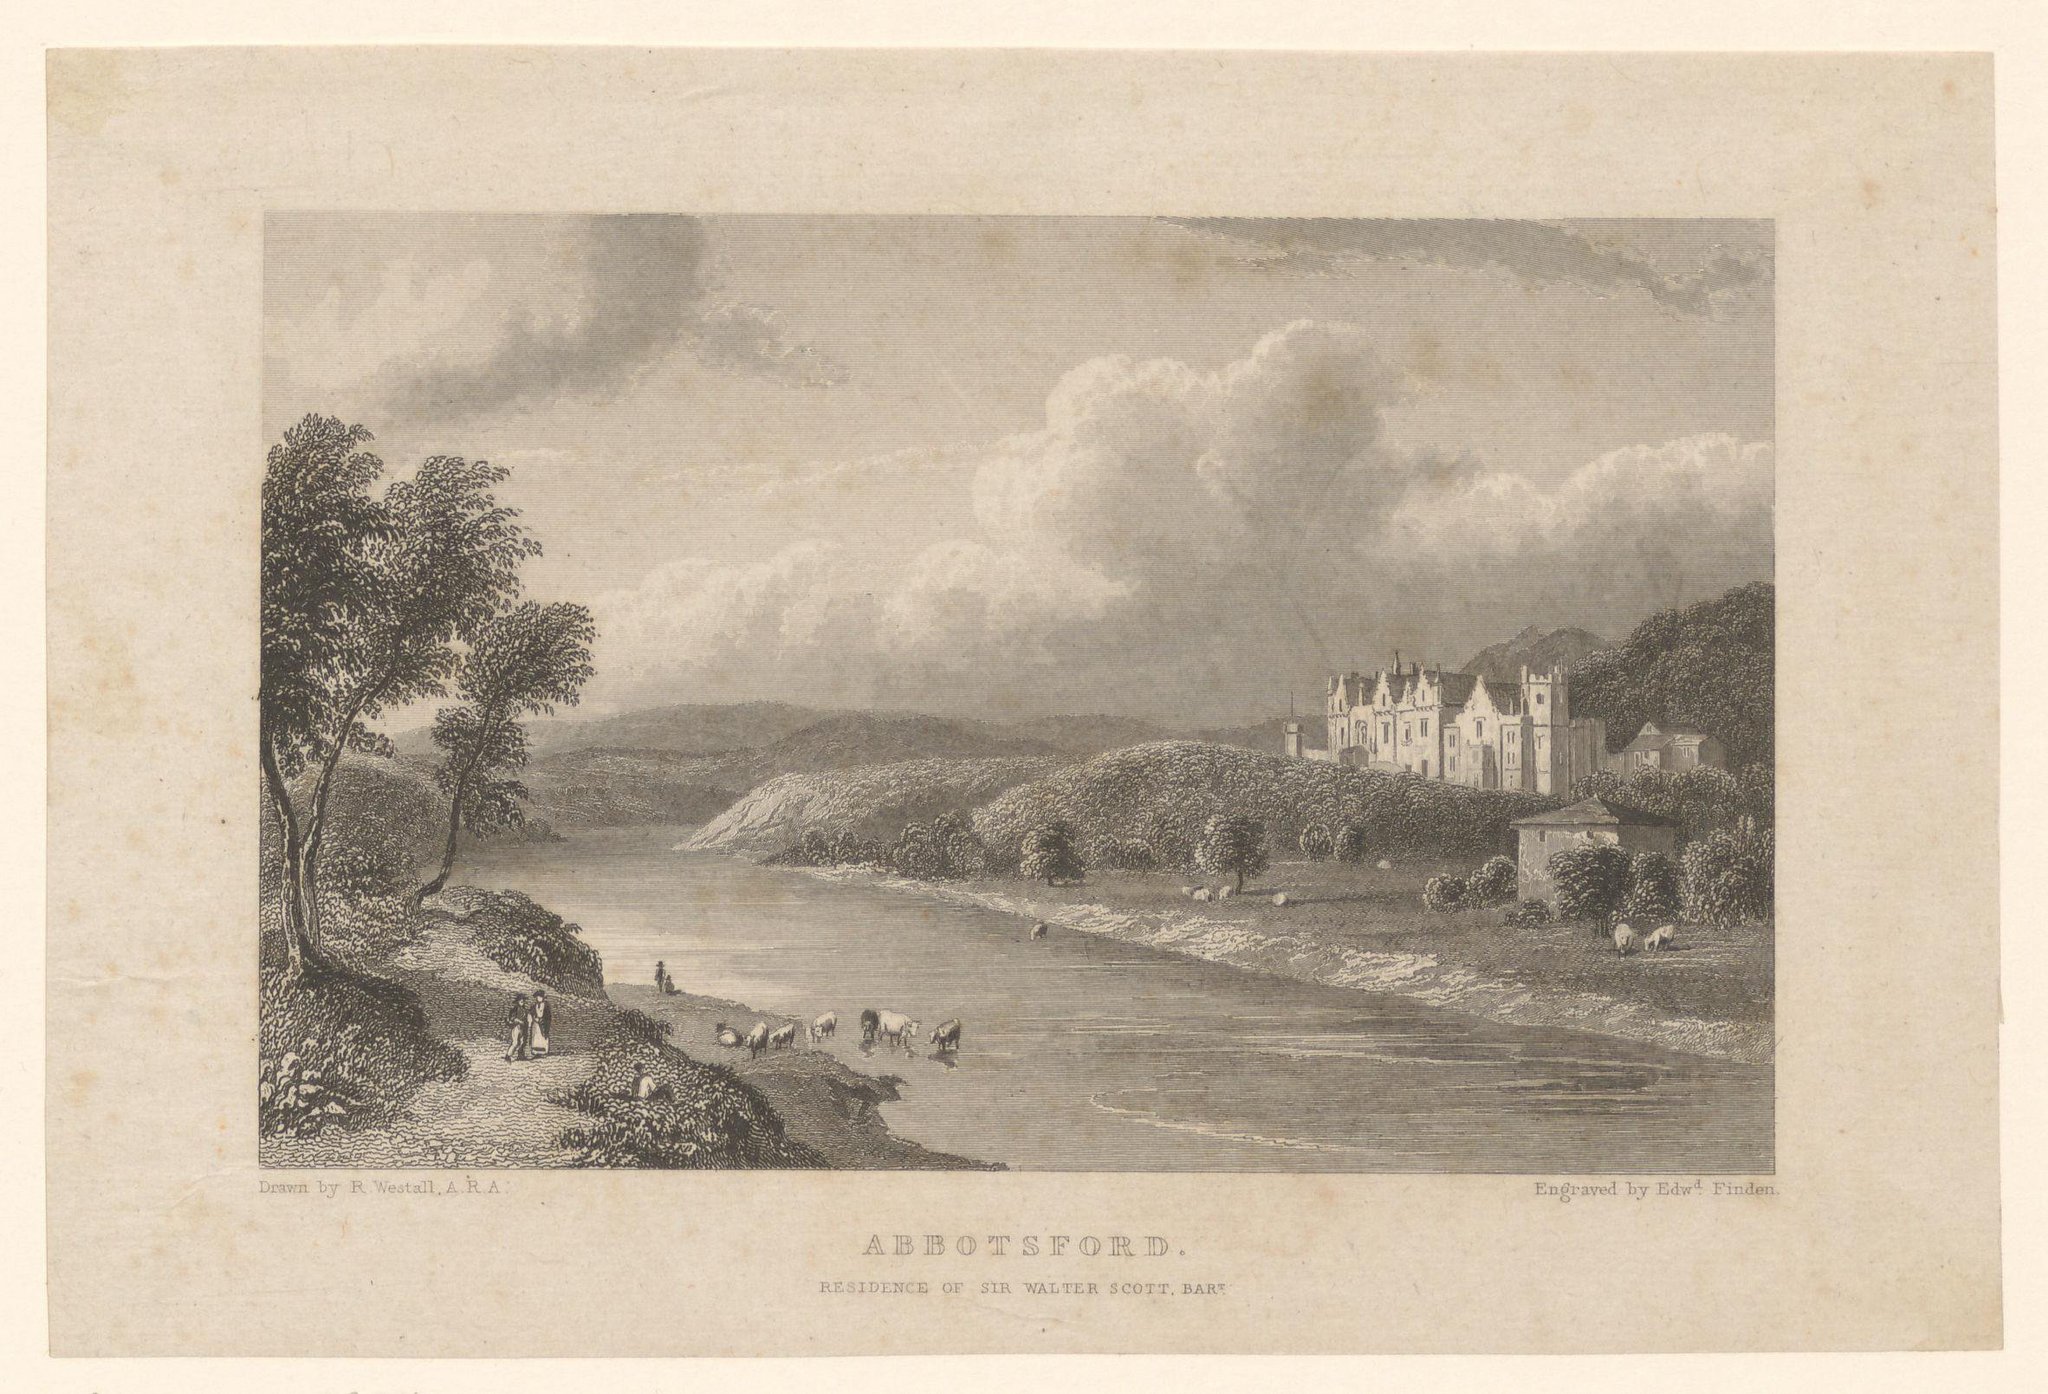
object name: print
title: Landschappen in Groot-Brittannië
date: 1829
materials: paper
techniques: etching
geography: london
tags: walter scott, river, country-house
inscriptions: collector's mark: Lugt 2228